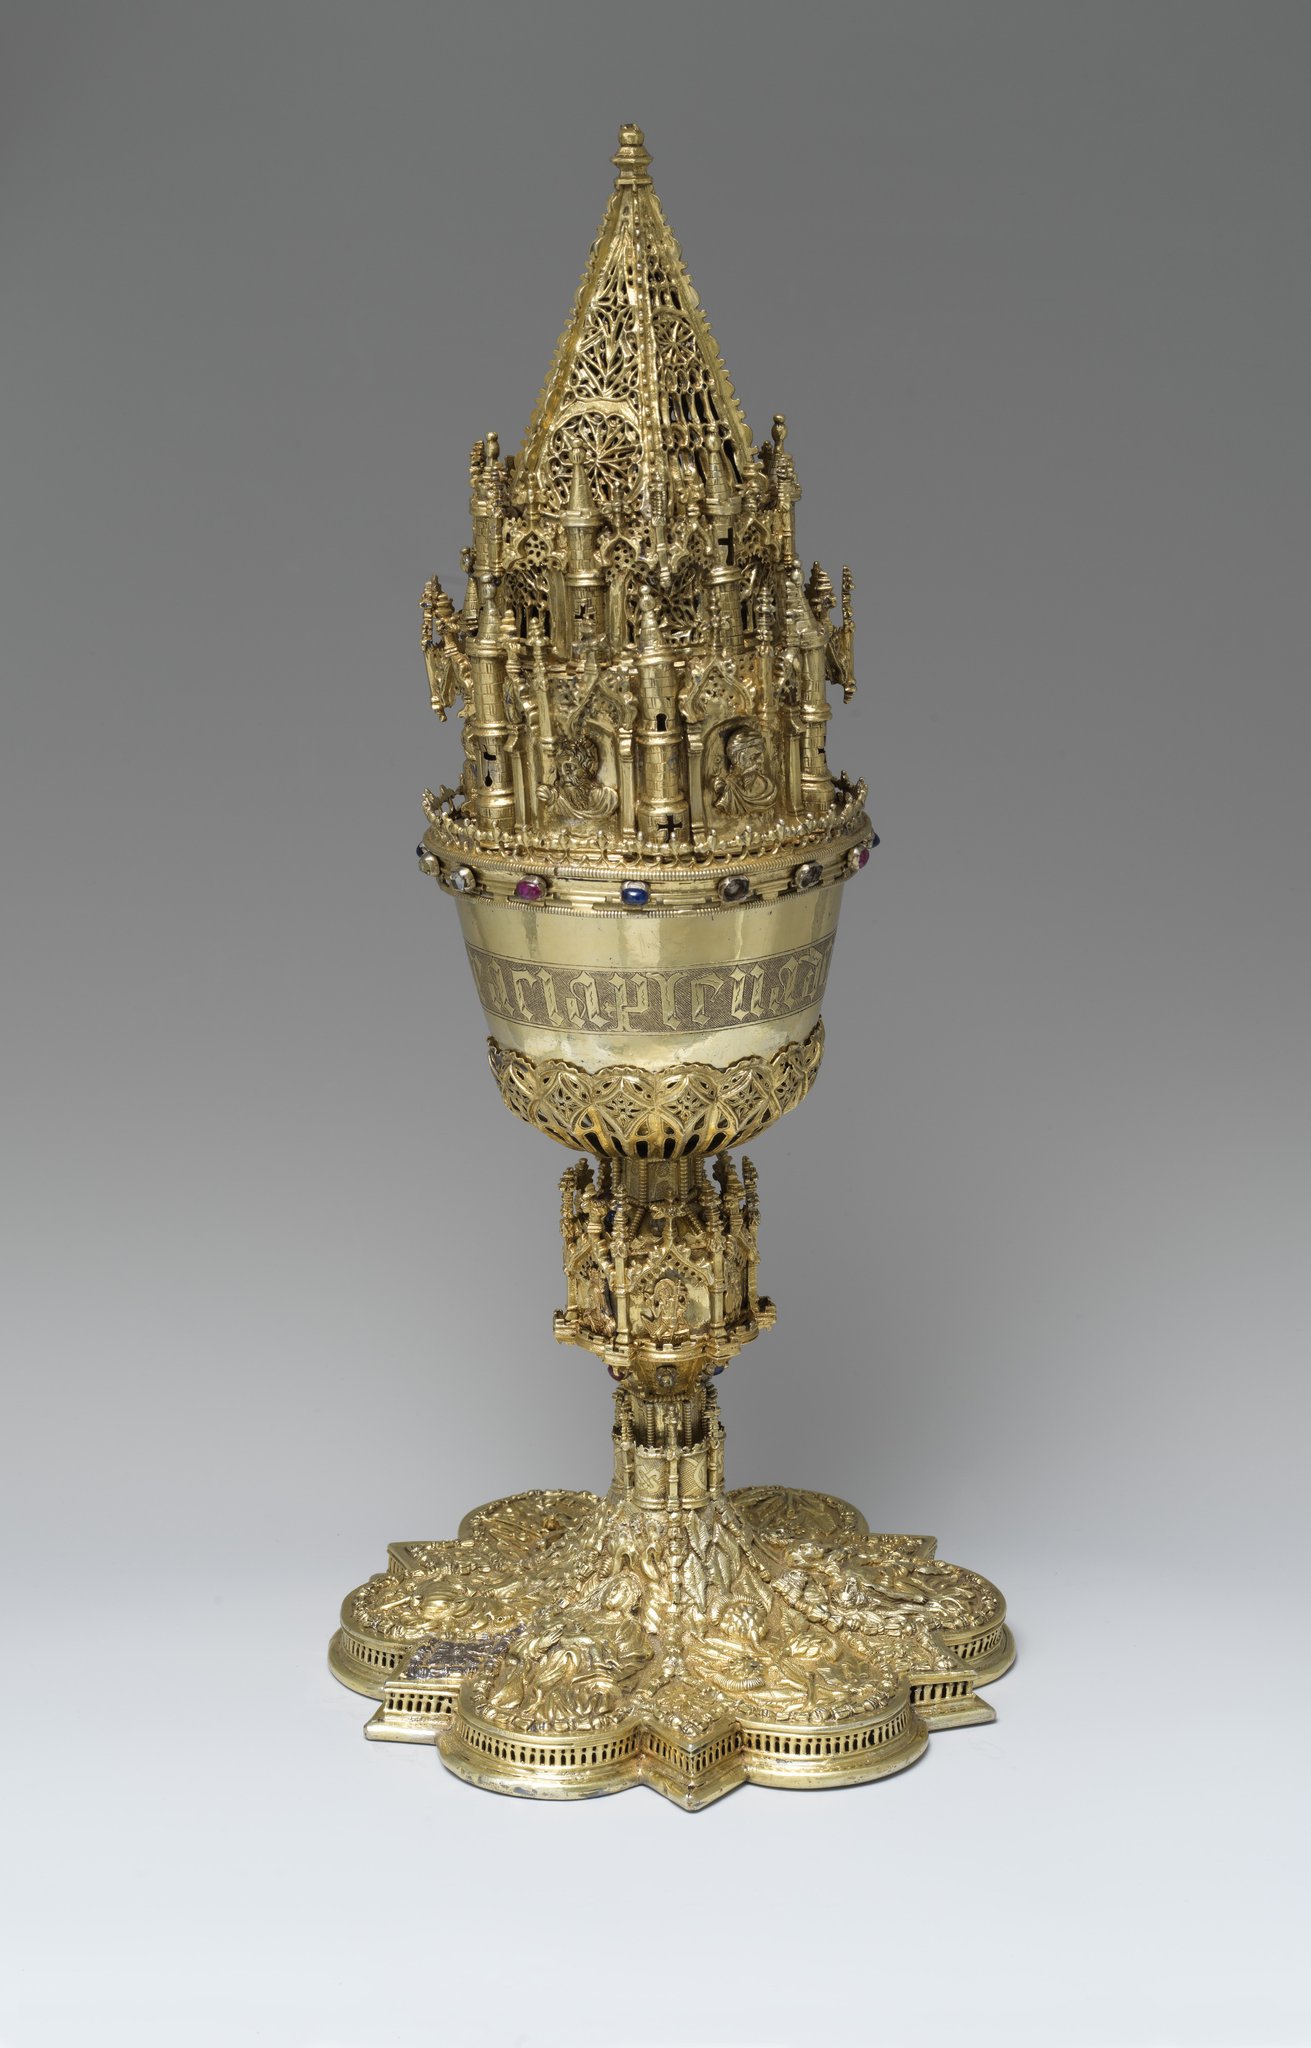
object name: chalice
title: Covered Chalice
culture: spanish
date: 1467-1500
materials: diamond, gemstone, silver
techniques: gilding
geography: spain